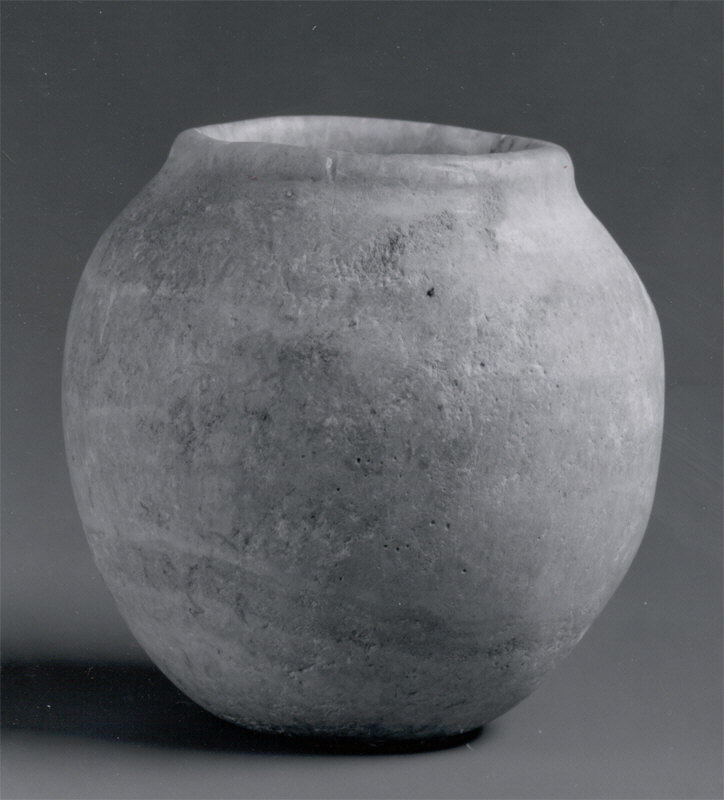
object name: jar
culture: bactria-margiana archaeological complex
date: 2333-1668 BCE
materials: marble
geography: bactria-margiana